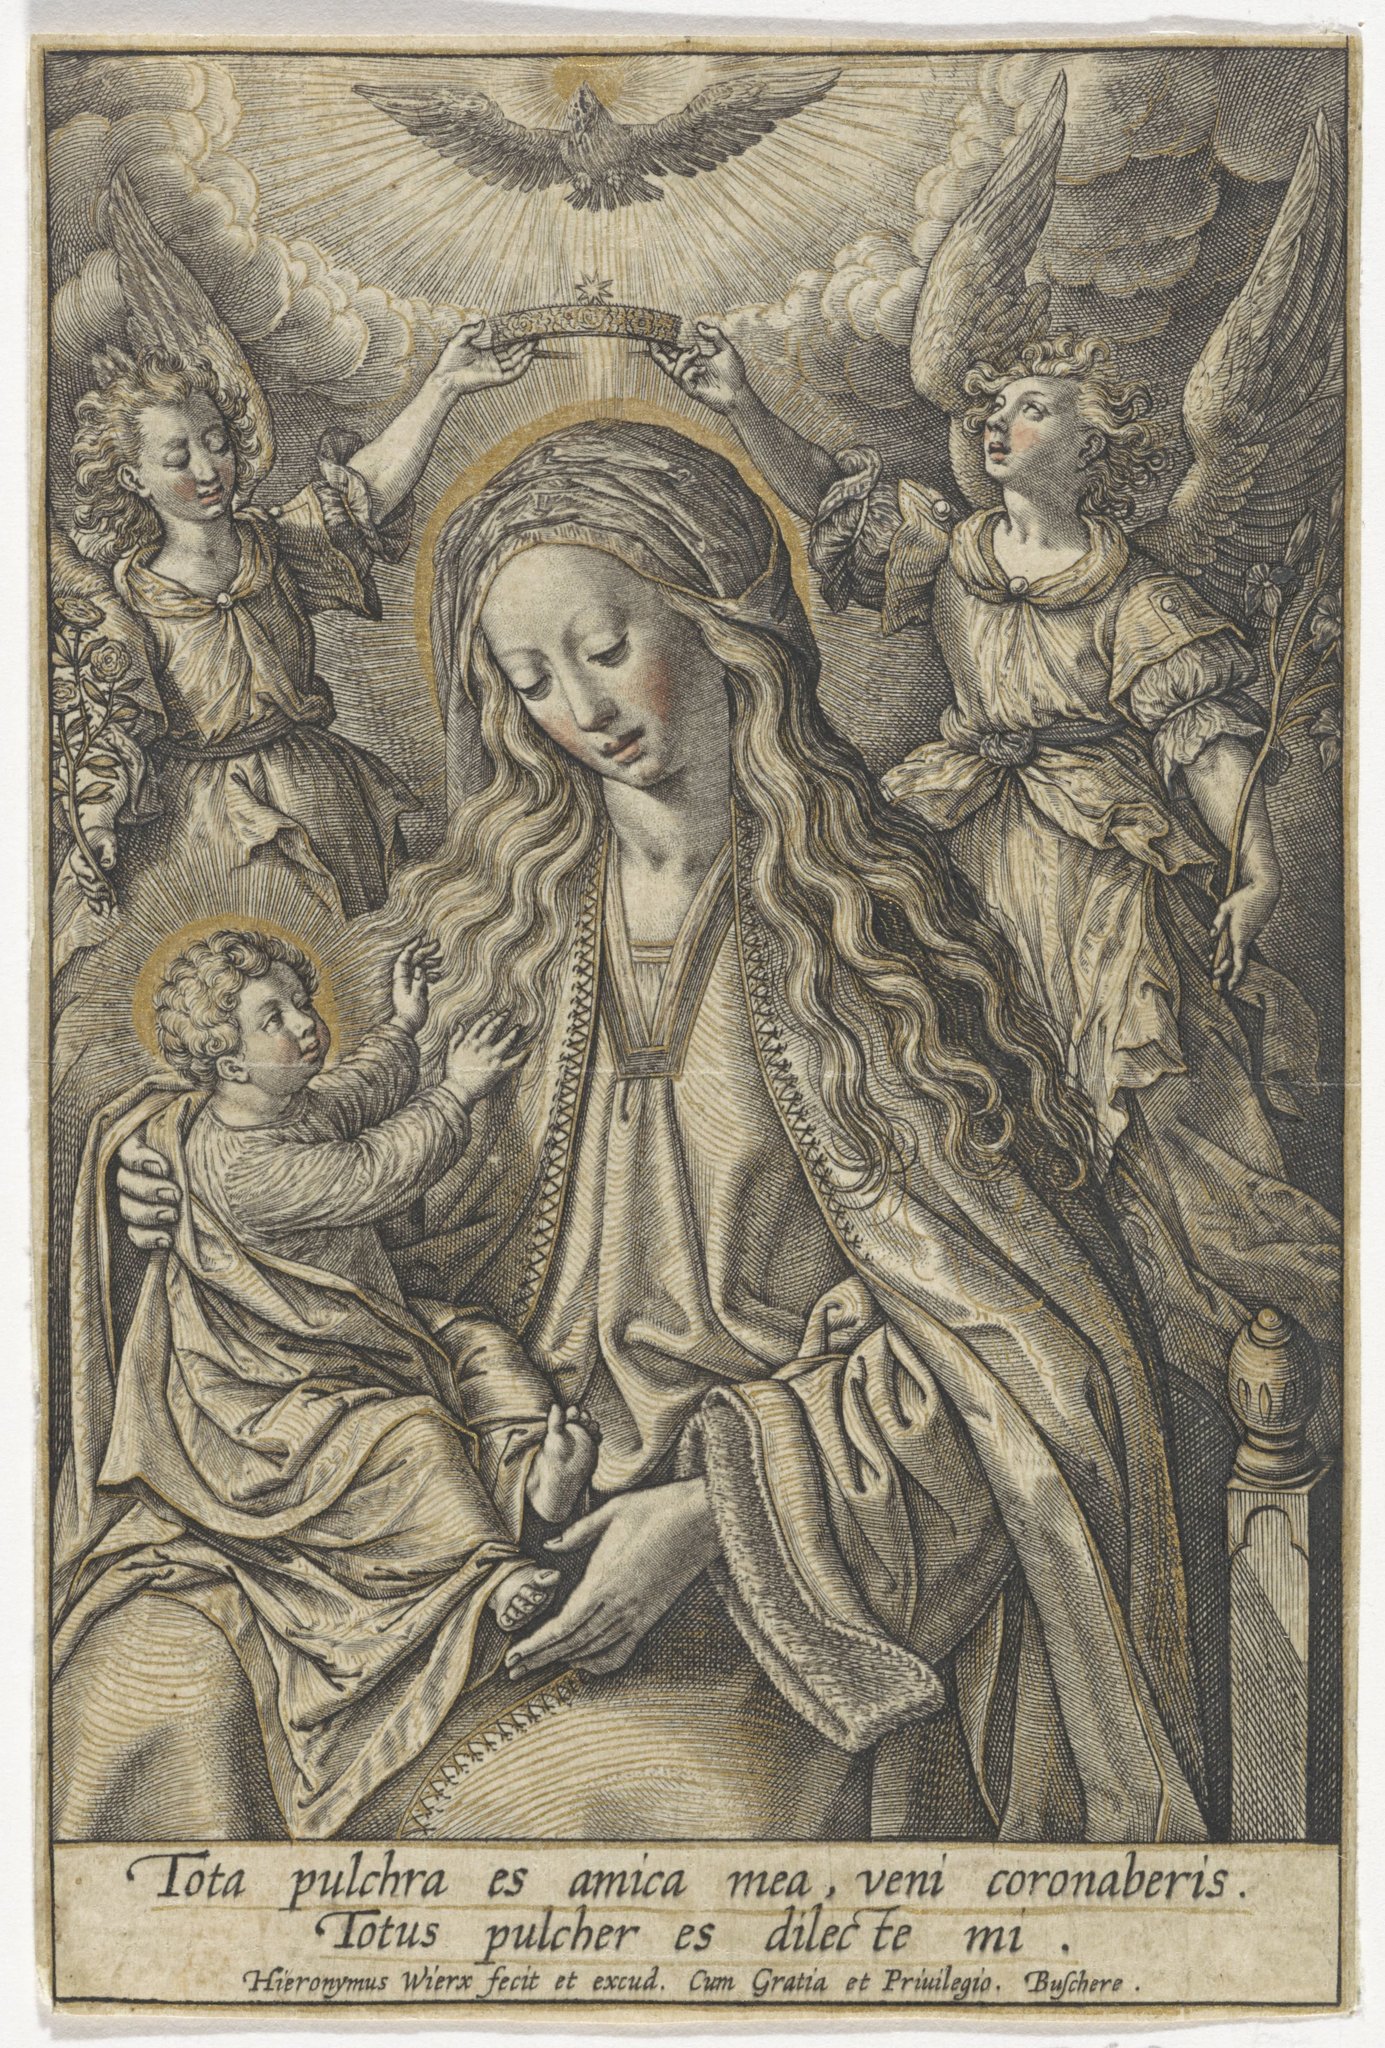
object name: print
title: Maria met Christuskind, gekroond door twee engelen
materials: paper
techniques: engraving, hand coloring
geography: antwerp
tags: coronation of mary by one or more angels, madonna (i.e. mary with the christ-child) accompanied or surrounded by others (+ angel(s)), holy ghost represented as a dove (in flames)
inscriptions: collector's mark: Lugt 240, number: ‘38. - 40.’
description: Maria zit met het Christuskind op schoot. Het Kind reikt naar haar. Maria wordt gekroond door twee engelen. Boven haar hoofd de duif van de Heilige Geest. In de marge een tweeregelig onderschrift in het Latijn.